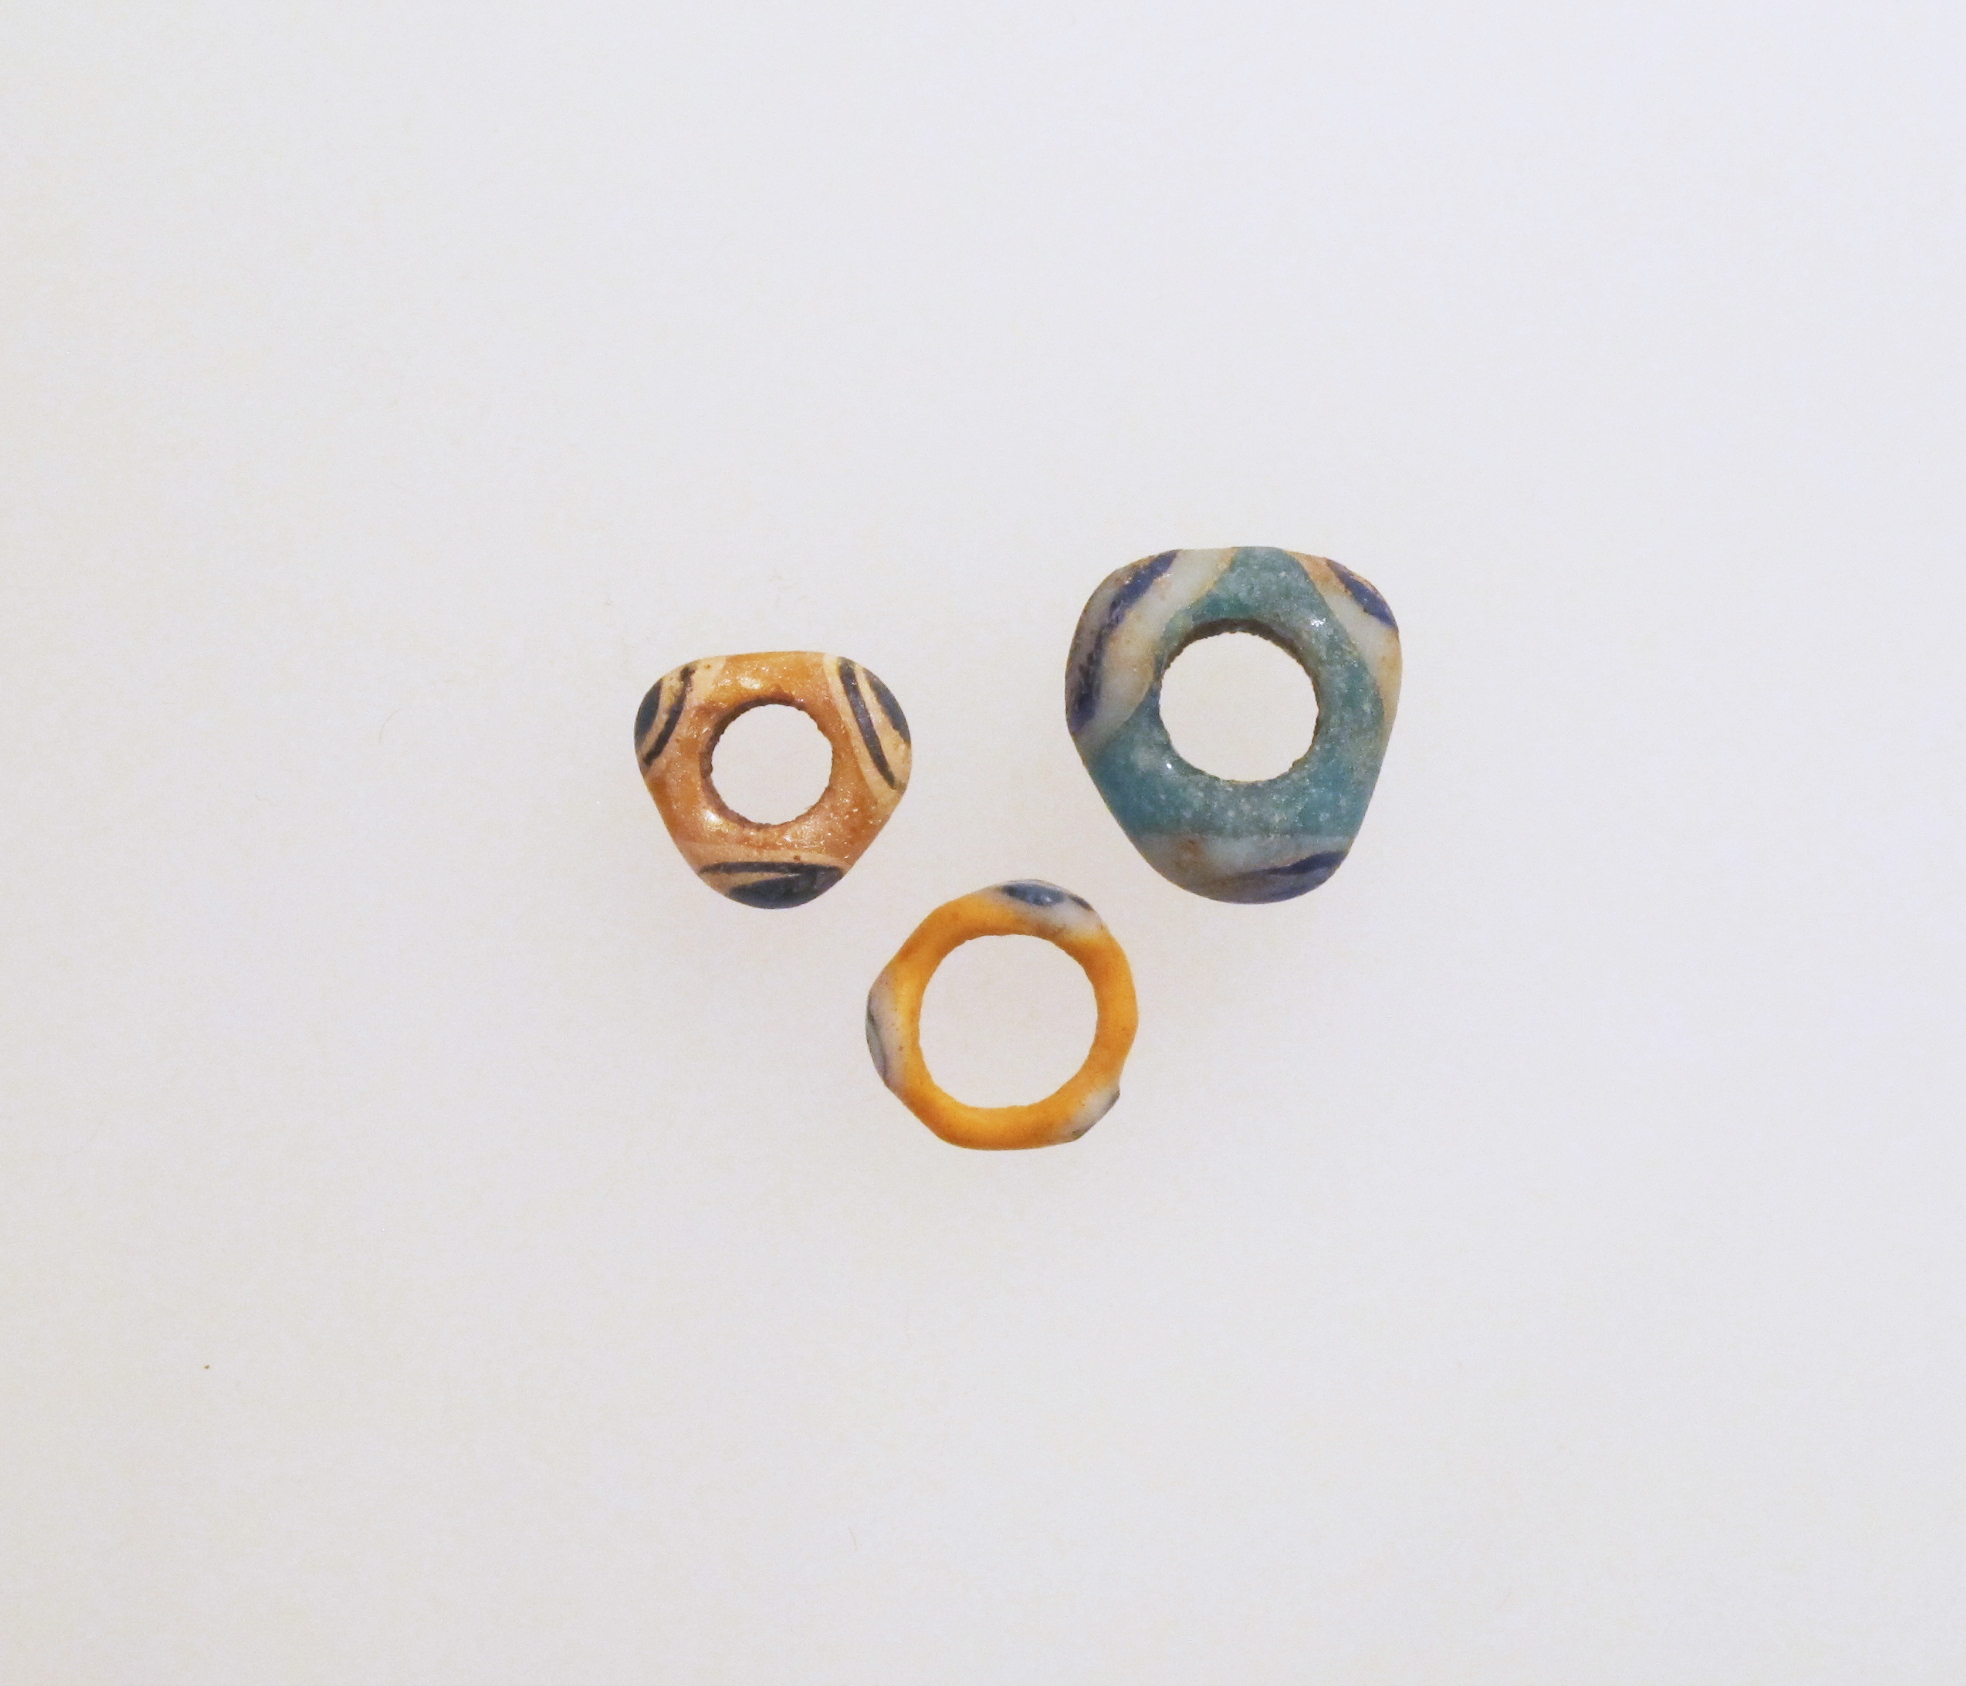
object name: bead, 3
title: Beads, 3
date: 7000 BCE-330 CE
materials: glass